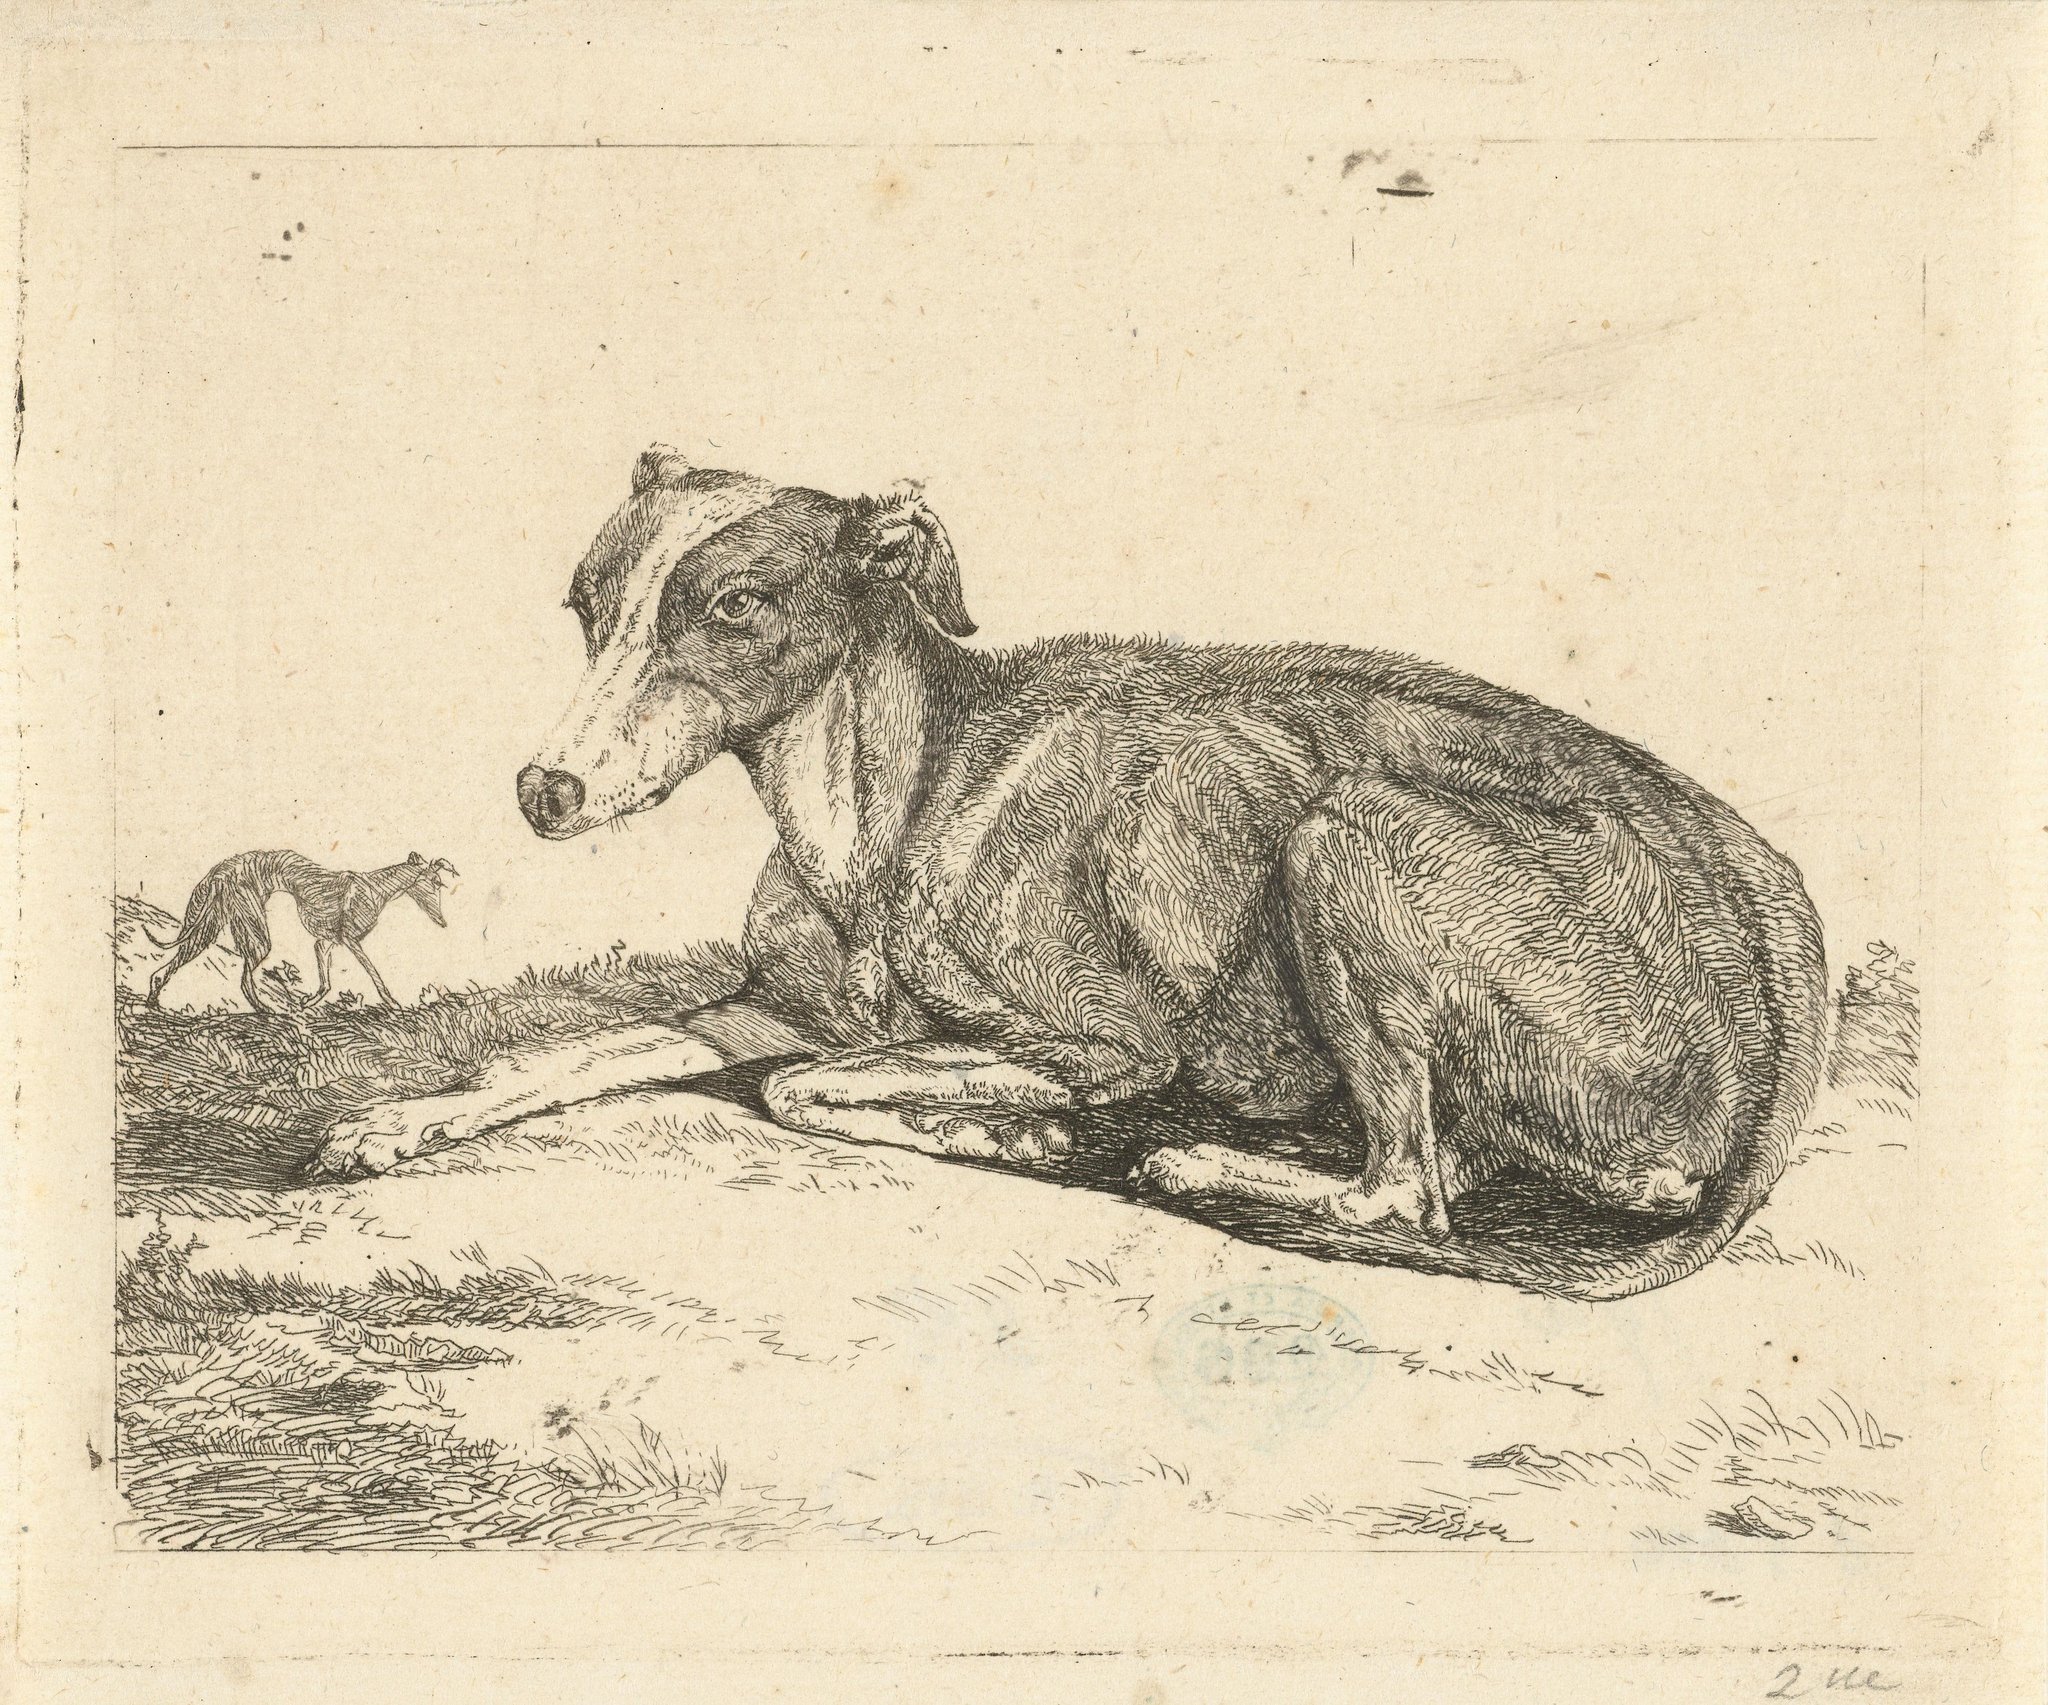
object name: print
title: Hazewindhonden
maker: jan dasveldt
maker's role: draughtsman, print maker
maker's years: 1770-1855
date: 1780-1855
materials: paper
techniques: etching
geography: amsterdam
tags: dog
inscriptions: collector's mark: Lugt 1962, collector's mark: Lugt 2228